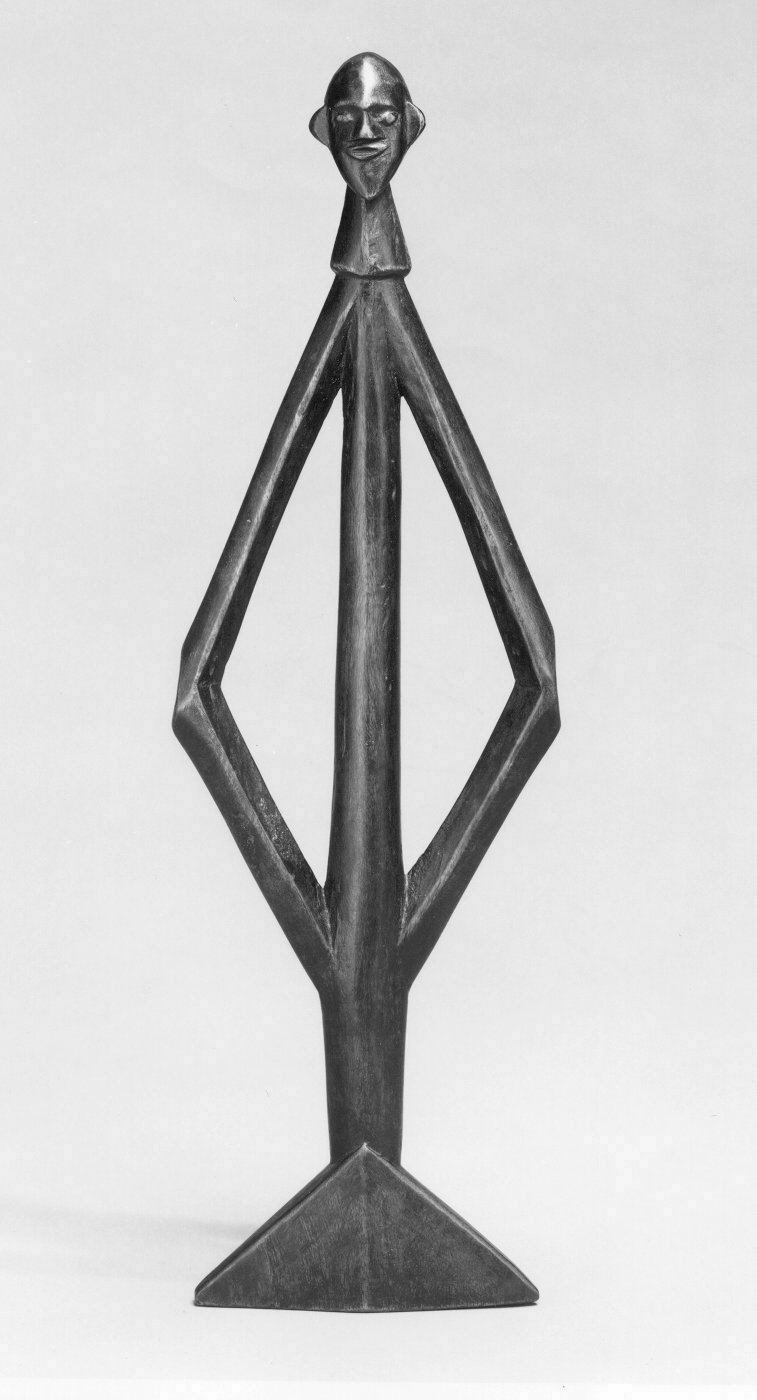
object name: whistle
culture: guronsi or mossi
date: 1801-1900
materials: wood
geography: burkina faso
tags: heads